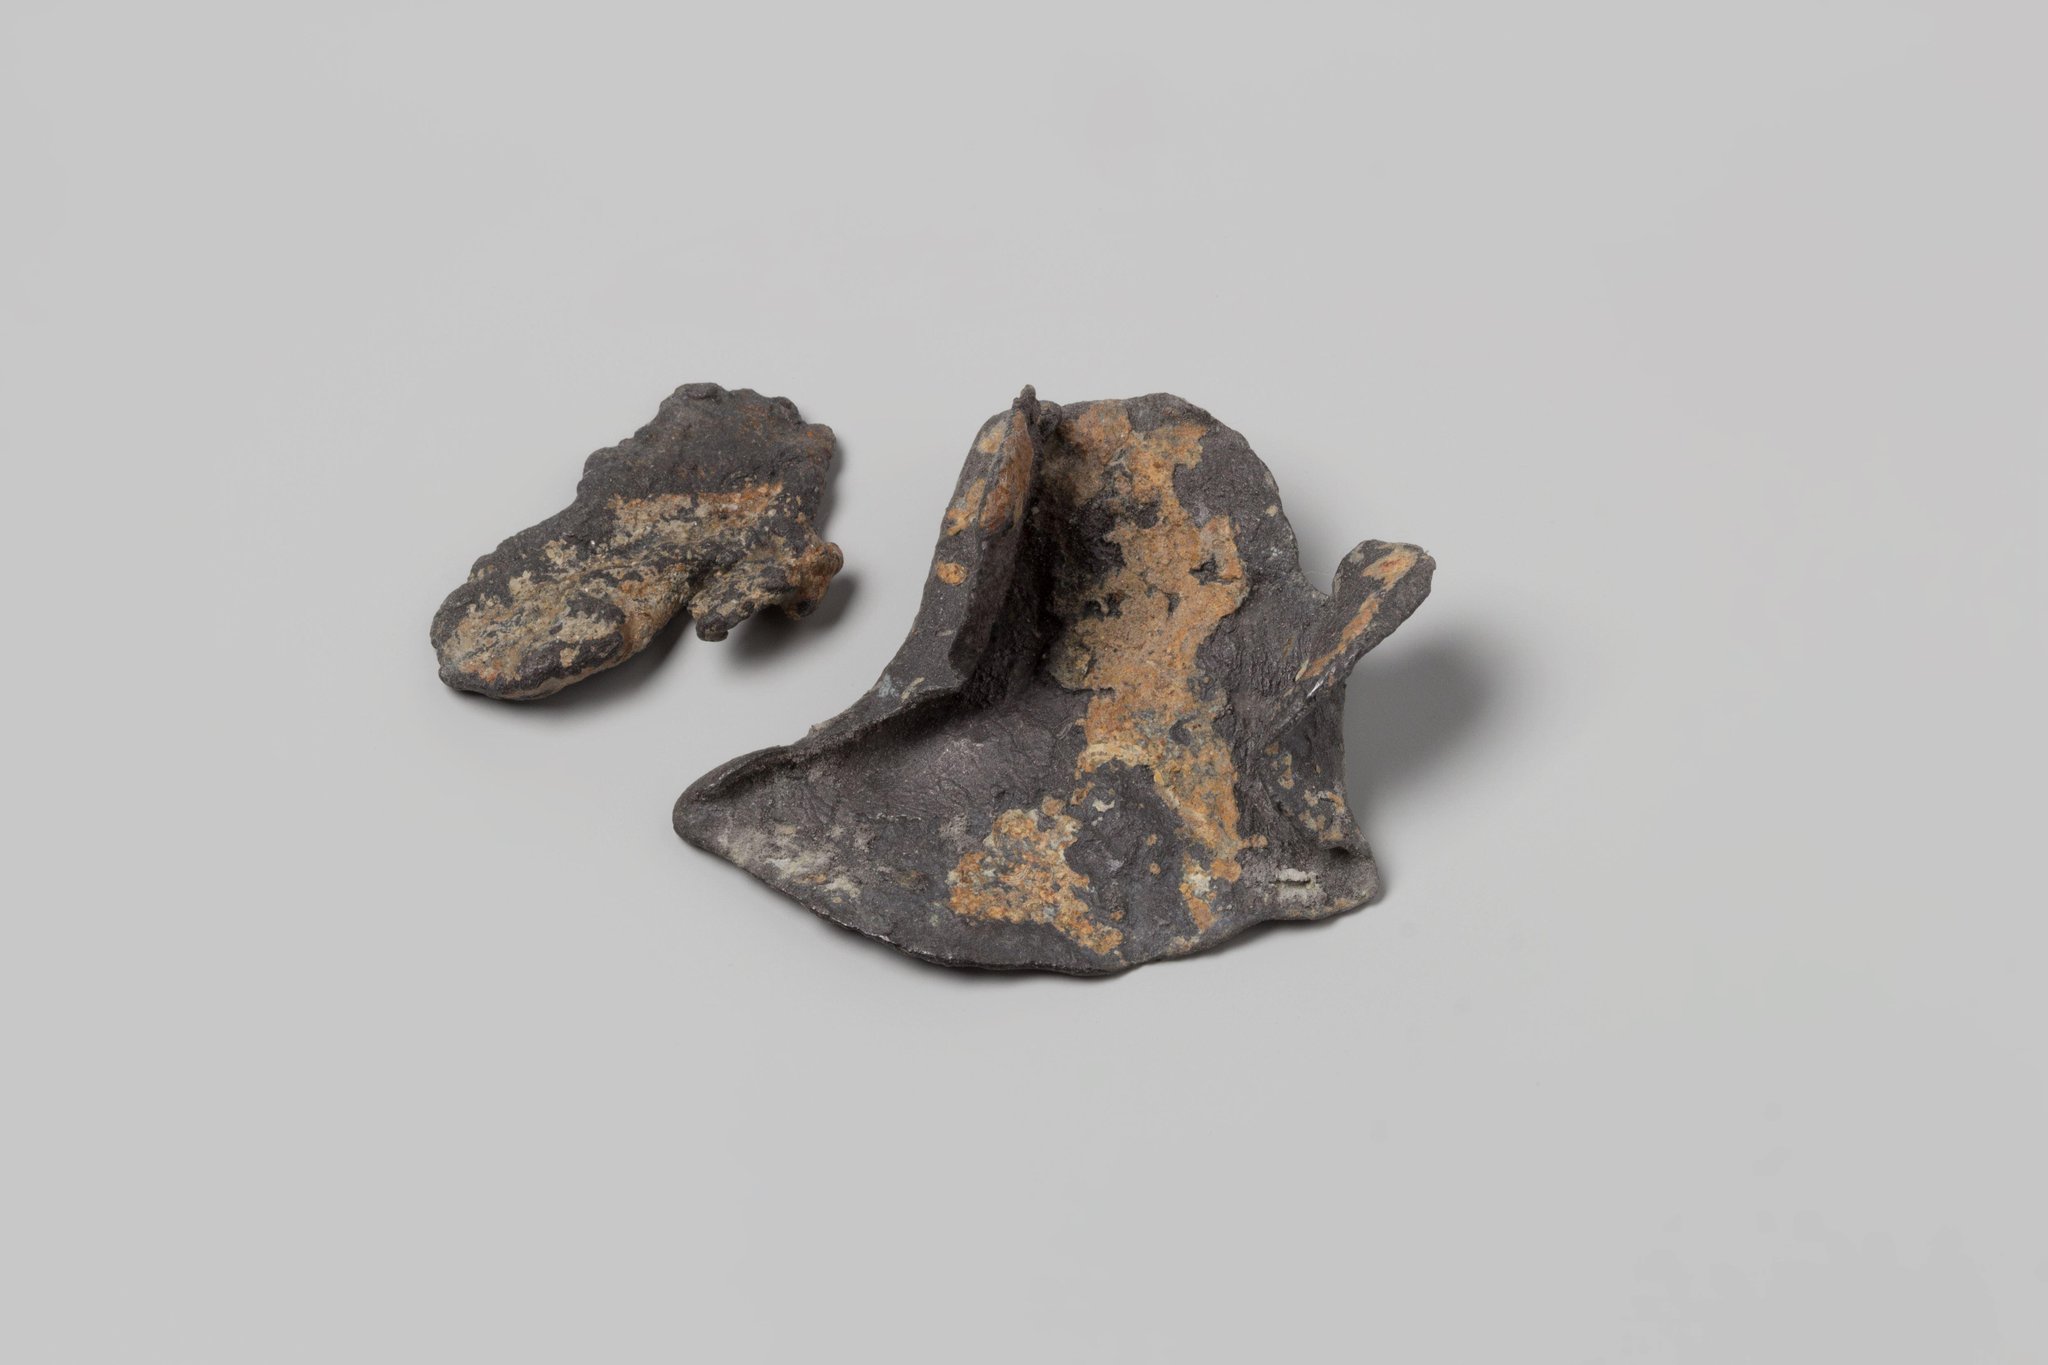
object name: fragment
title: Fragmenten lood uit het wrak van de Oost-Indiëvaarder Hollandia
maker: Anonymous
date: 1700-1743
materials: lead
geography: netherlands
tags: verenigde oostindische compagnie, hollandia (schip), annet